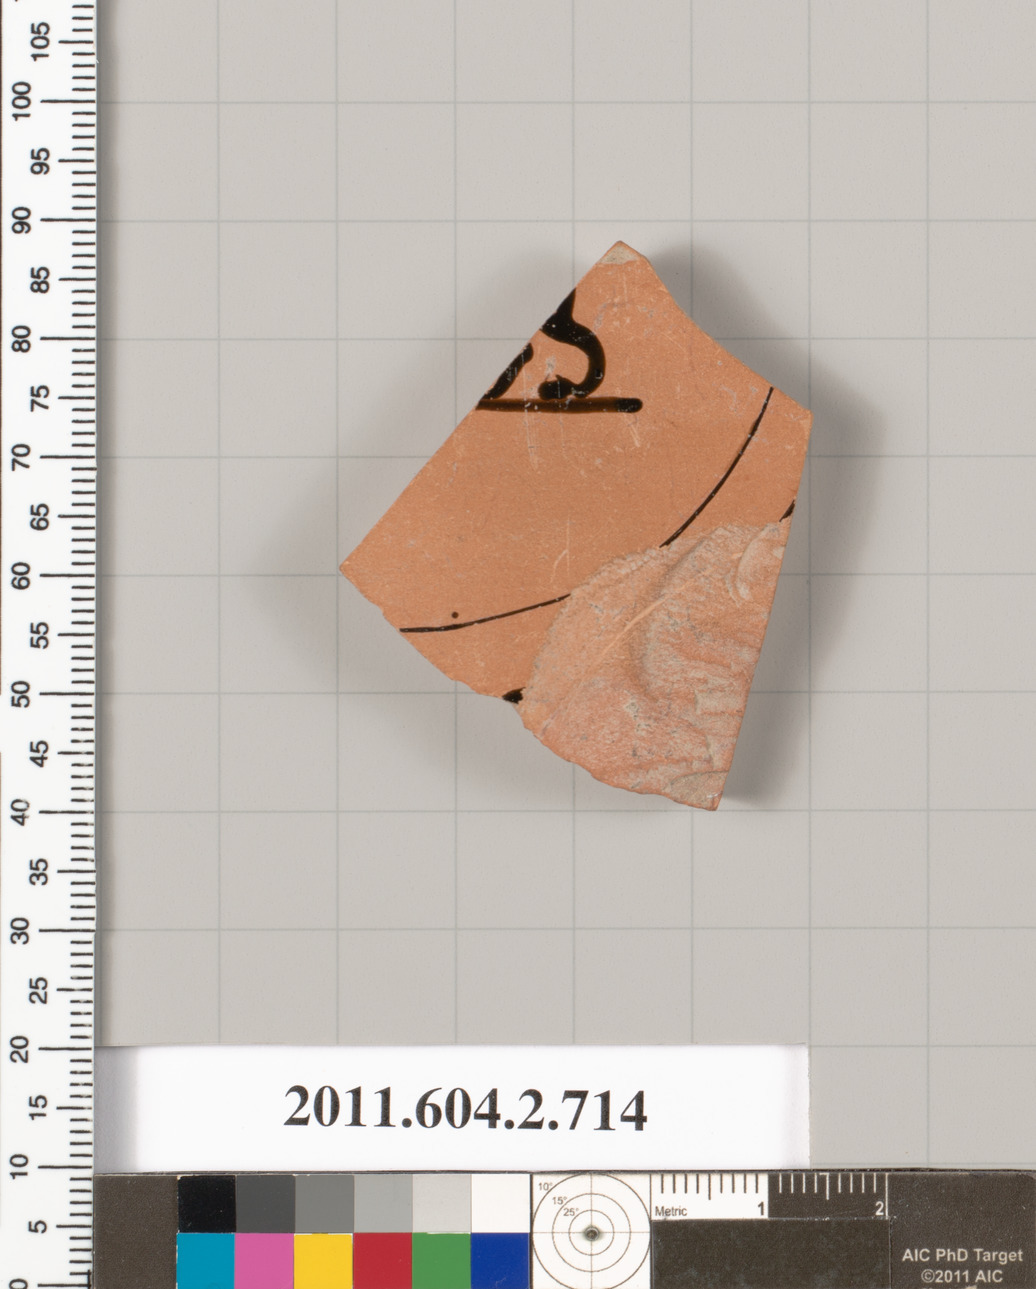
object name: calyx krater fragment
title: Terracotta fragment of a calyx-krater (bowl for mixing wine and water)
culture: greek, attic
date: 475-451 BCE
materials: terracotta